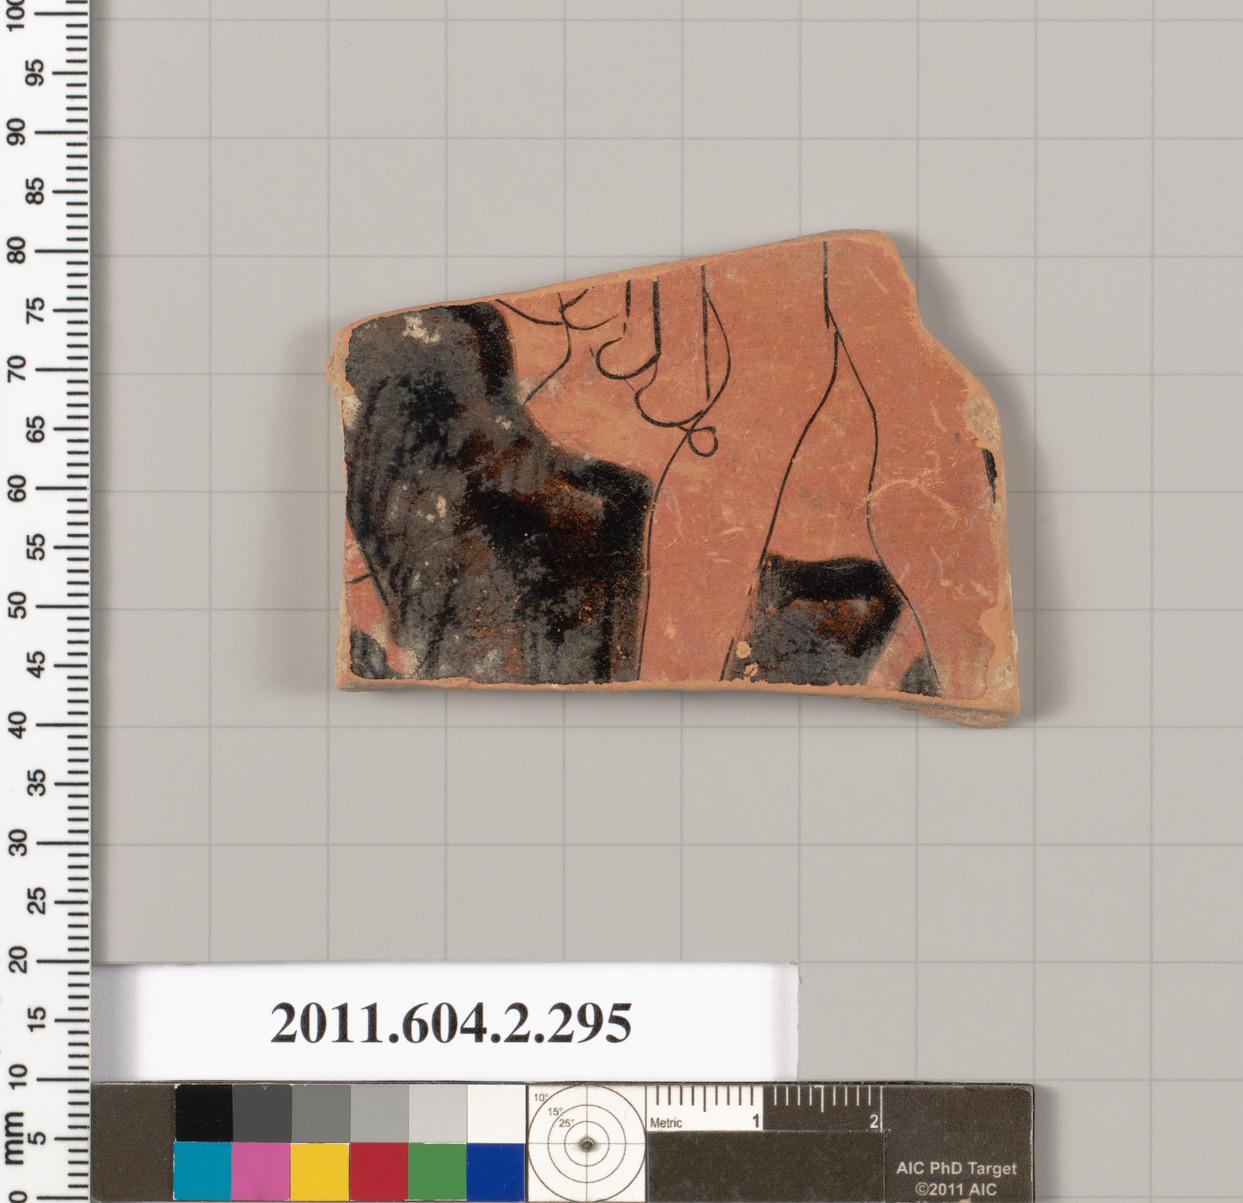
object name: column krater fragment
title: Terracotta fragment of a column-krater (bowl for mixing wine and water)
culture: greek, attic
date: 475-451 BCE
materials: terracotta